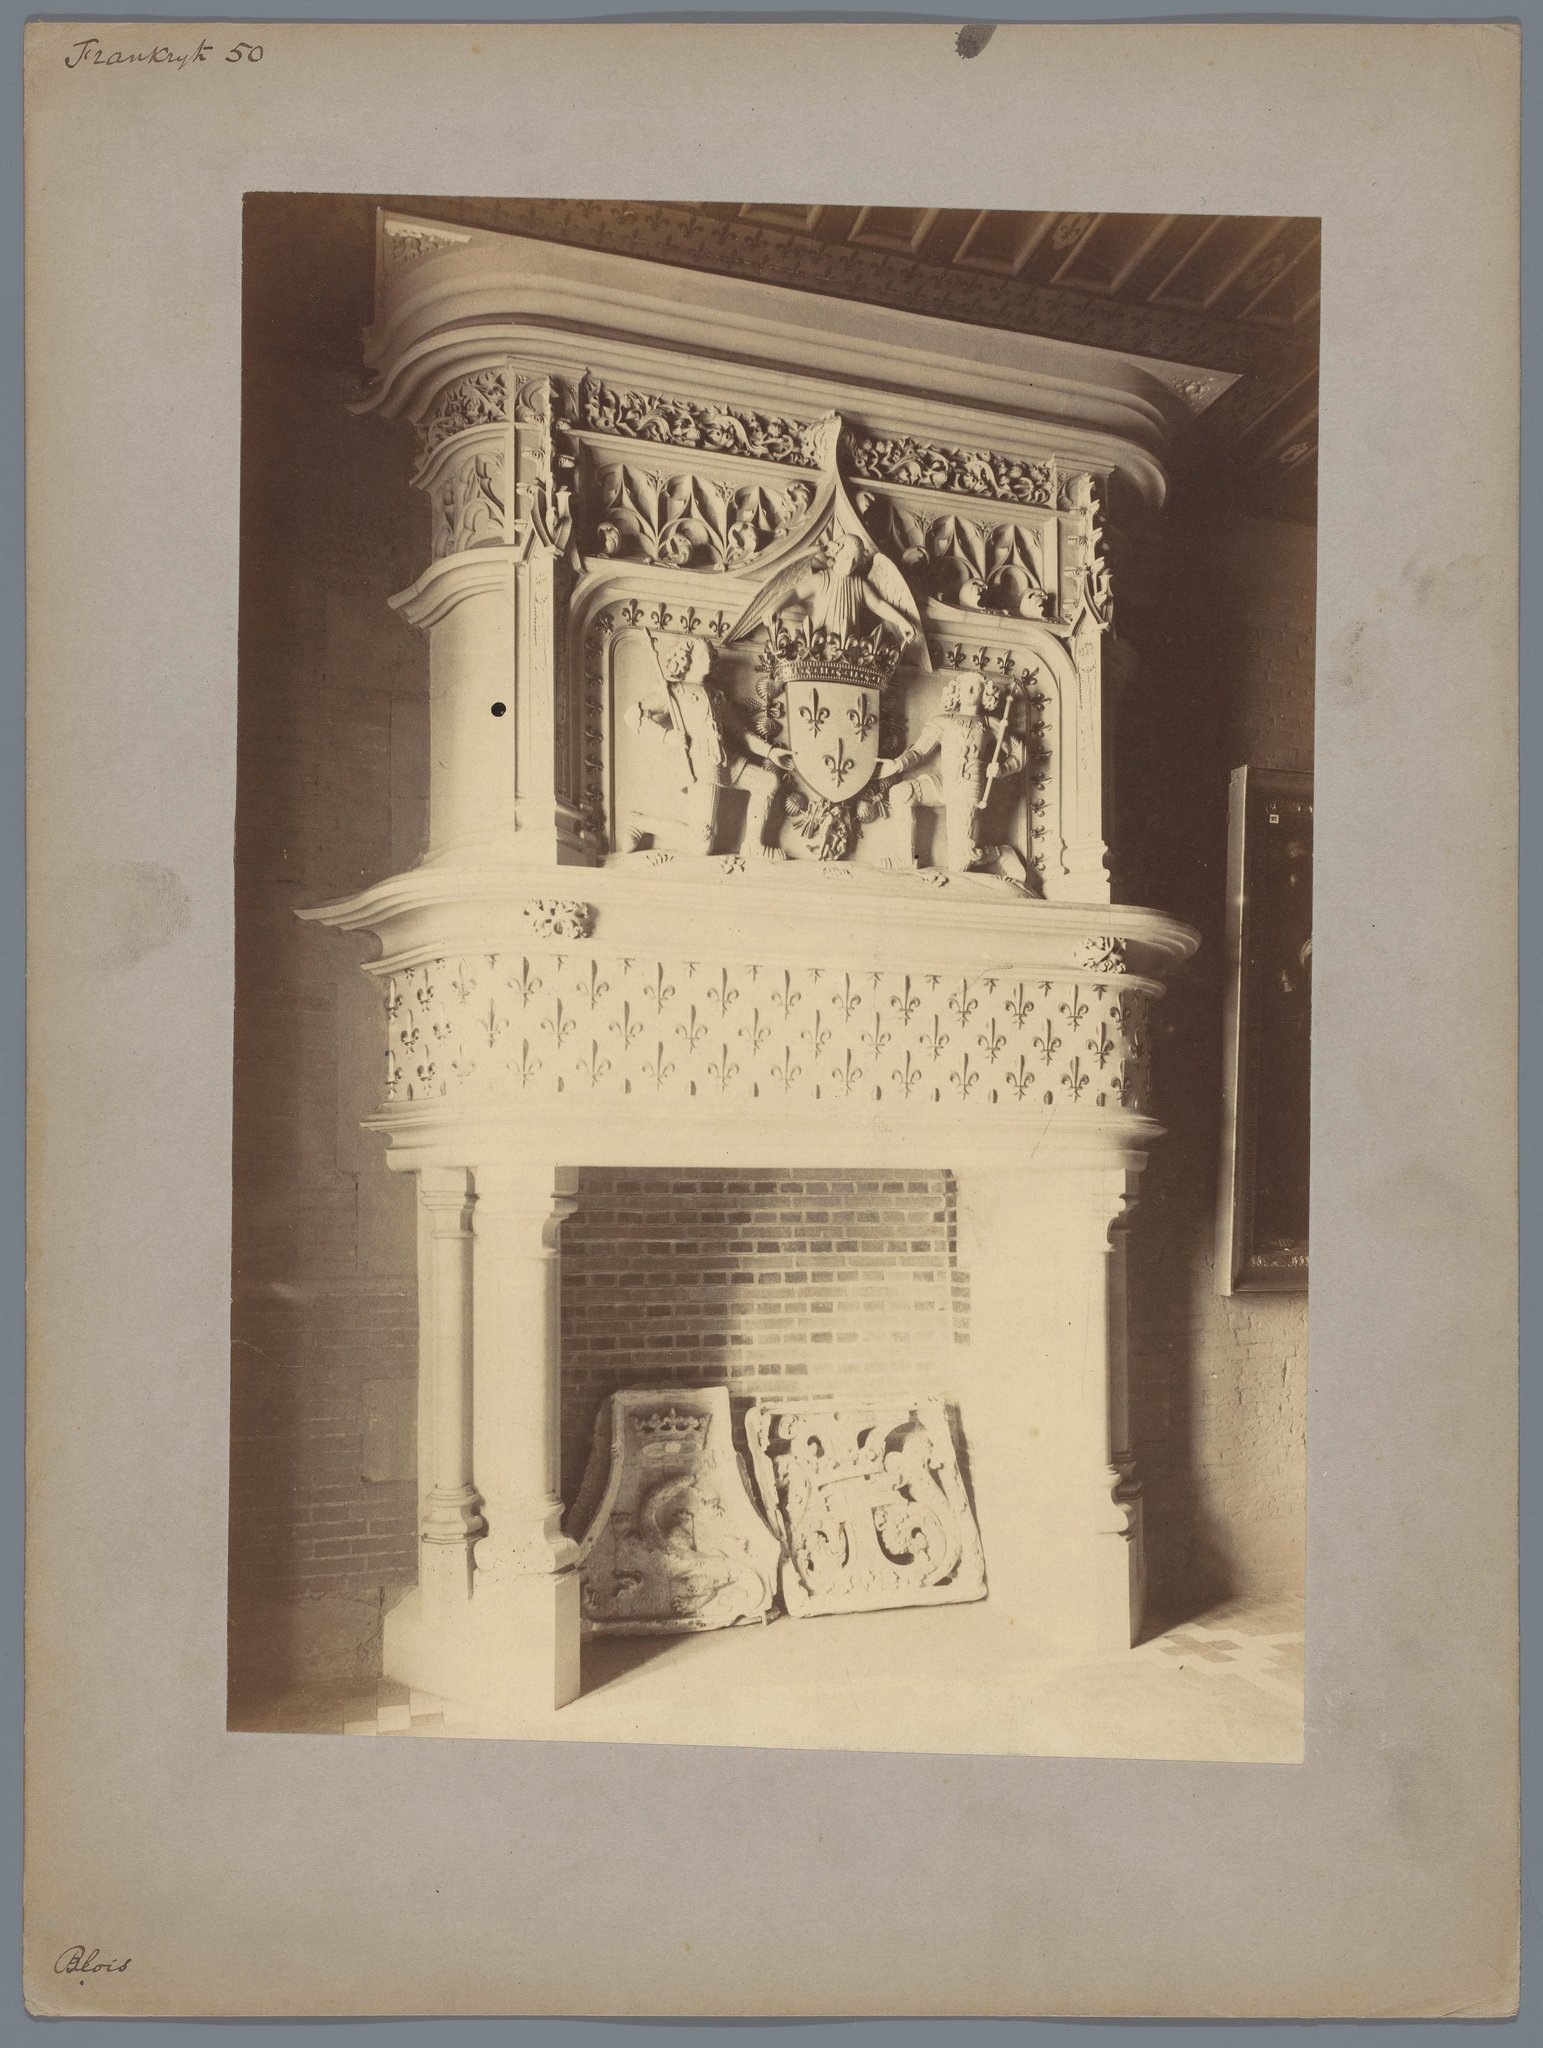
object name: photograph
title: Schoorsteenmantel in het kasteel van Blois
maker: Anonymous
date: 1850-1900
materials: cardboard, photographic support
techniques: albumen print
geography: blois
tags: chimney-piece, mantelpiece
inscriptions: collector's mark: ‘RIJKS [NORMAALSC]HOOL voor T[EEKENONDERWIJZERS] AMSTERDA[M]’, annotation: ‘Blois’, annotation: ‘Frankrijk 50’, annotation: ‘Blois’